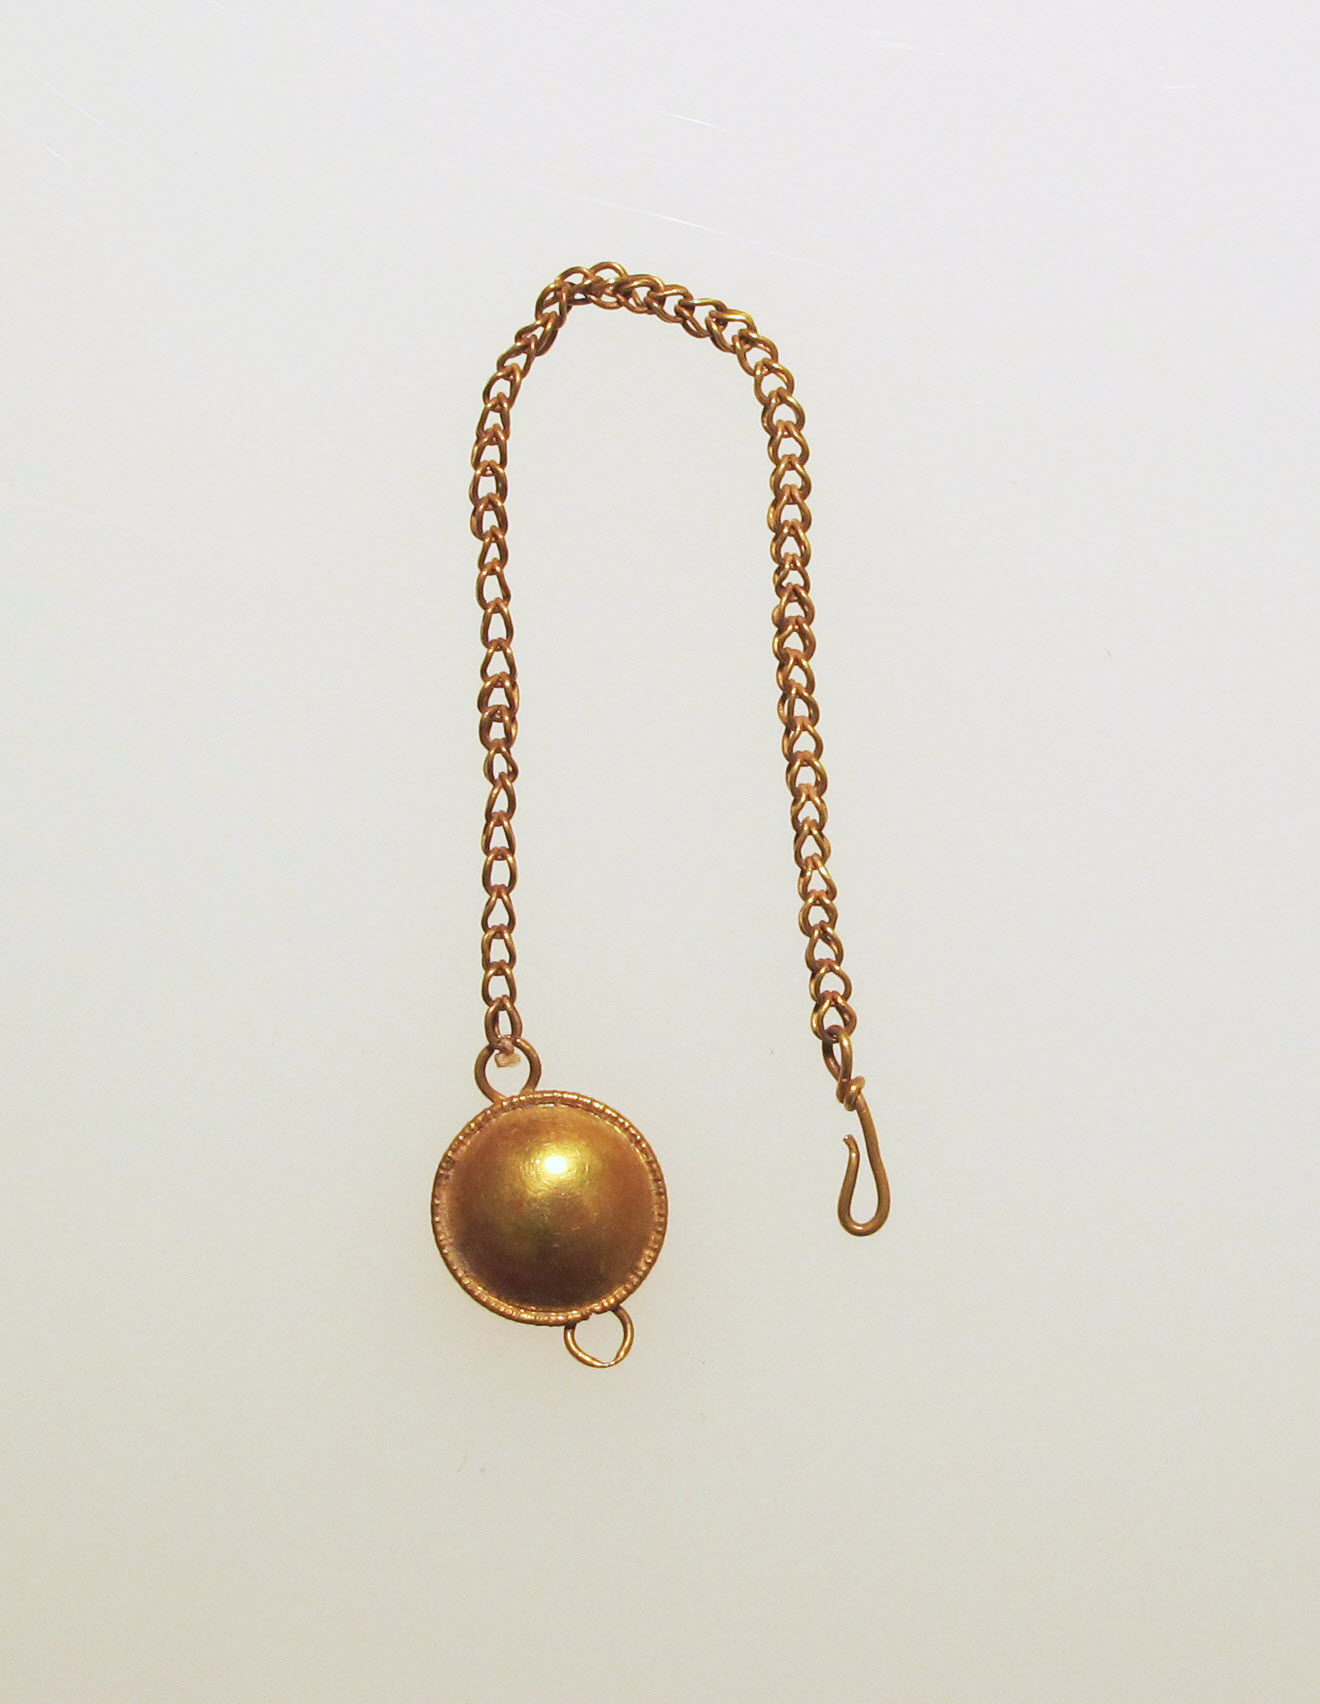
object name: earring, chain type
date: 7000 BCE-330 CE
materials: gold